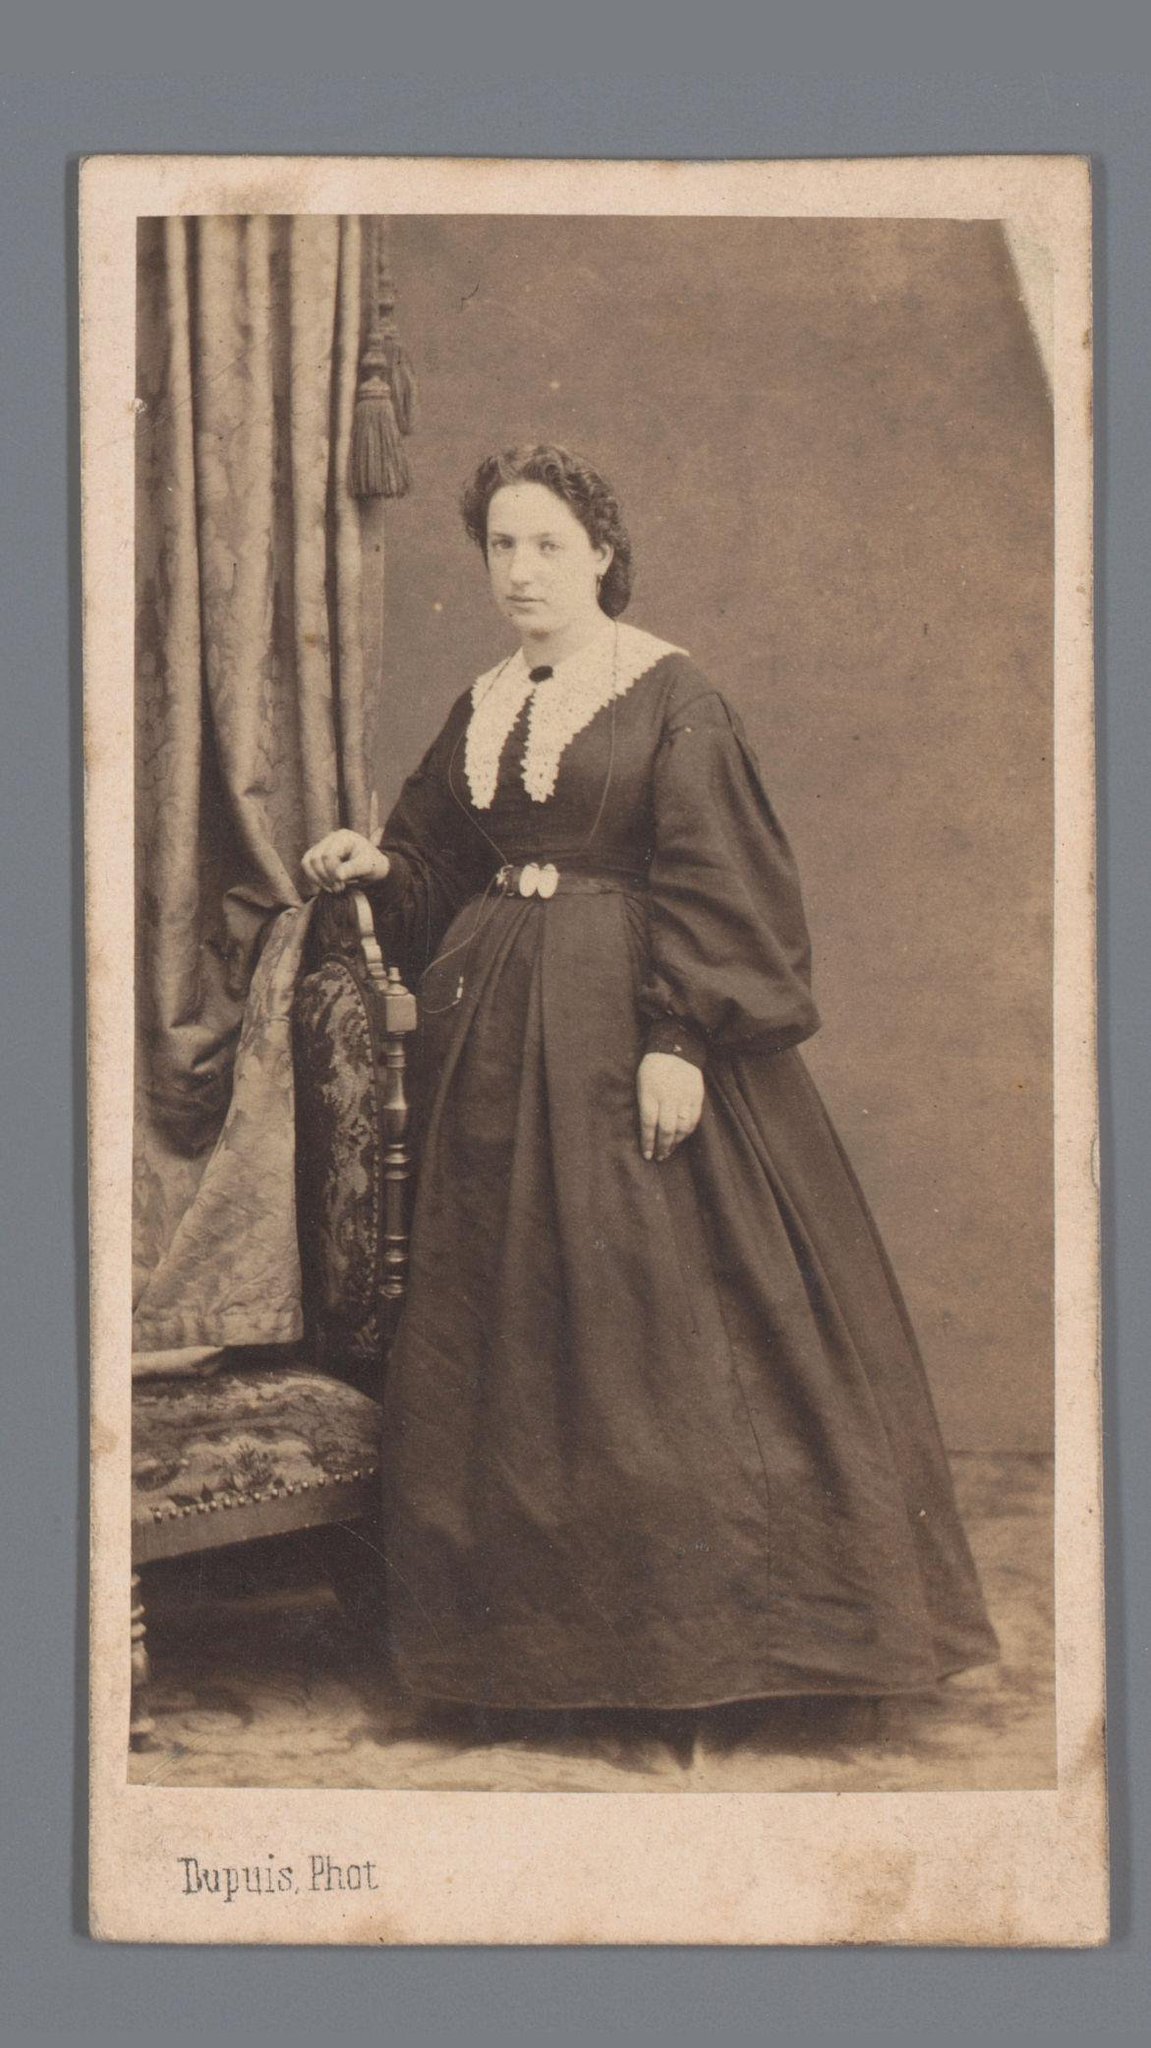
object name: carte de visite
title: Portret van een onbekende vrouw bij een stoel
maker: dupuis (fotograaf)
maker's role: fotograaf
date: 1855-1885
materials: cardboard, paper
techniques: albumen print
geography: paris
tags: adult woman, anonymous historical person portrayed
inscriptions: address: ‘Boult Sébastopol/ 141/ PARIS.’